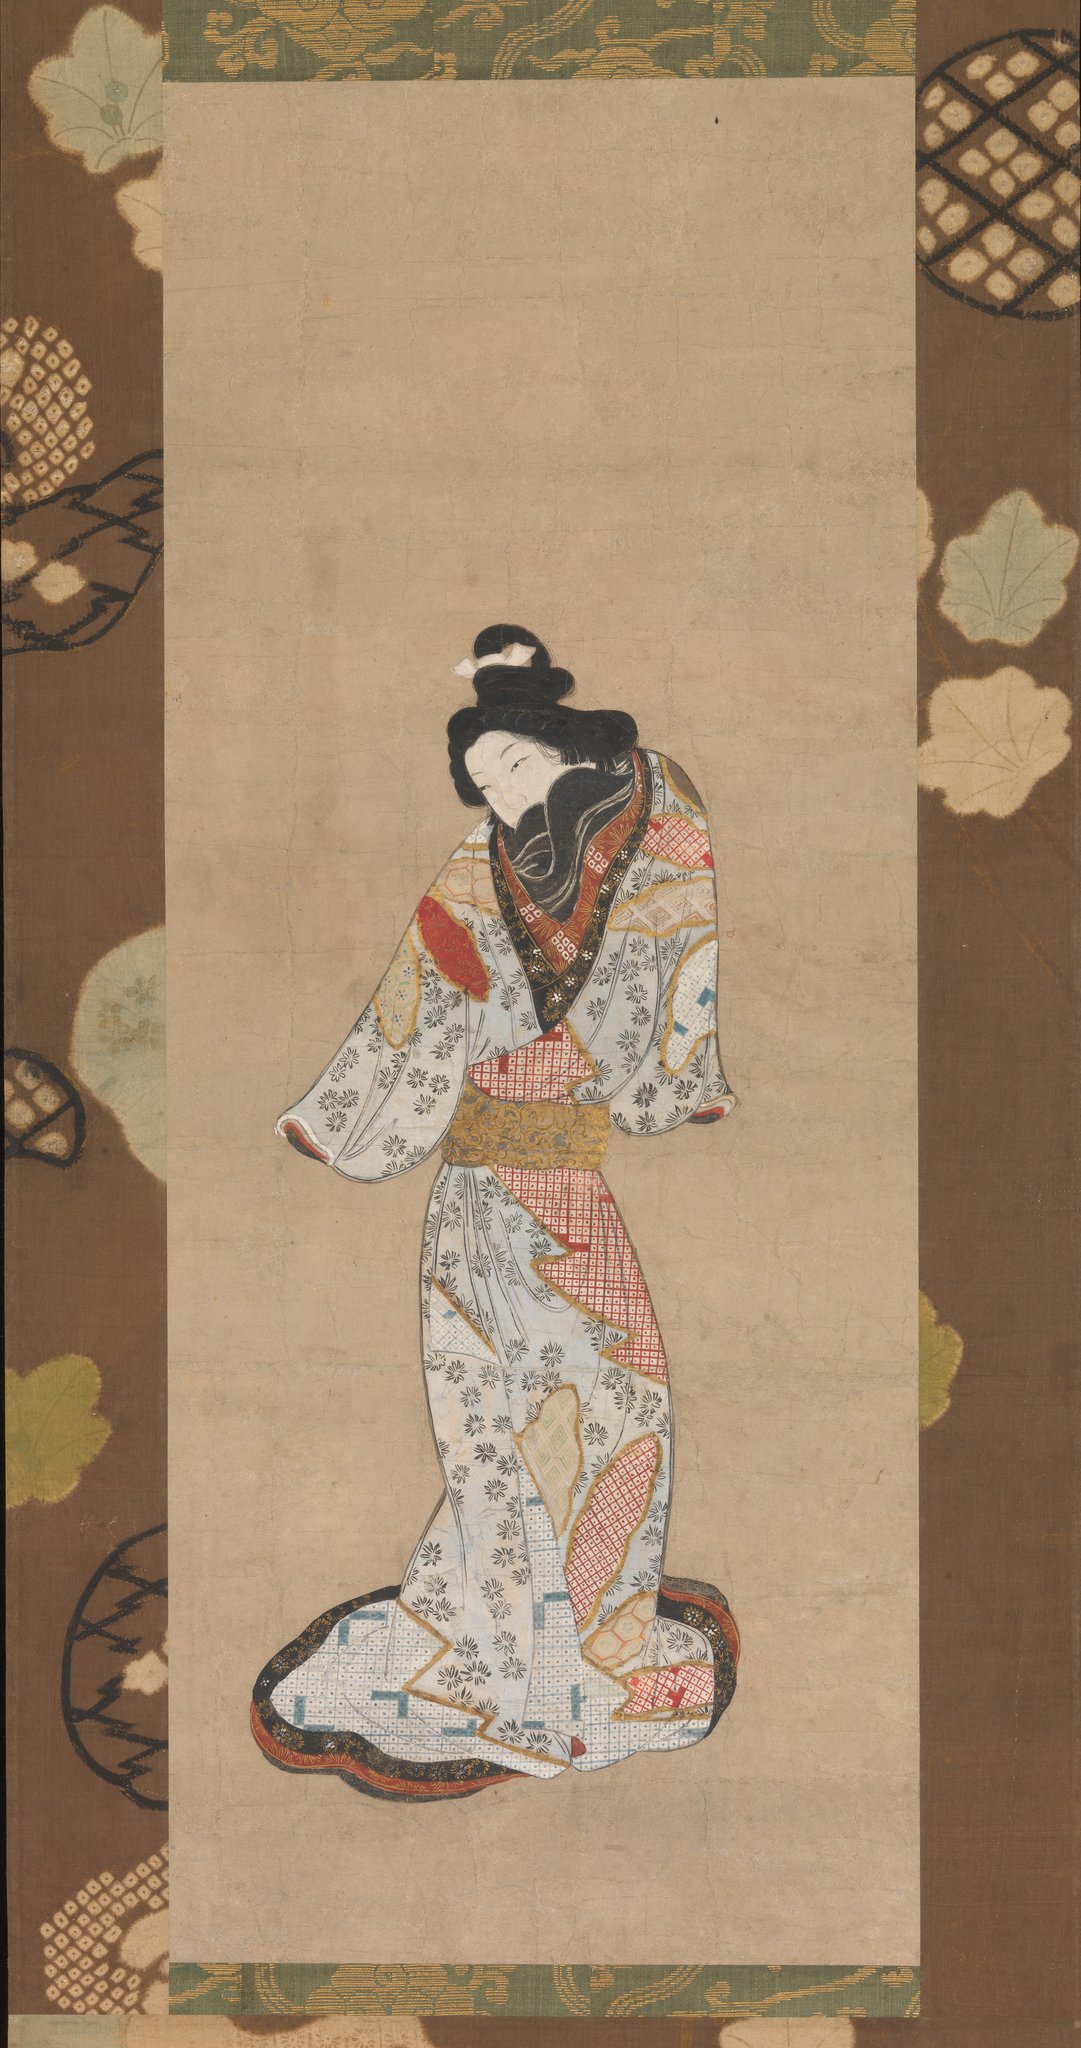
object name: hanging scroll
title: Beauty of the Kanbun Era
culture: japanese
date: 1667-1700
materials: gold, ink, paper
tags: women